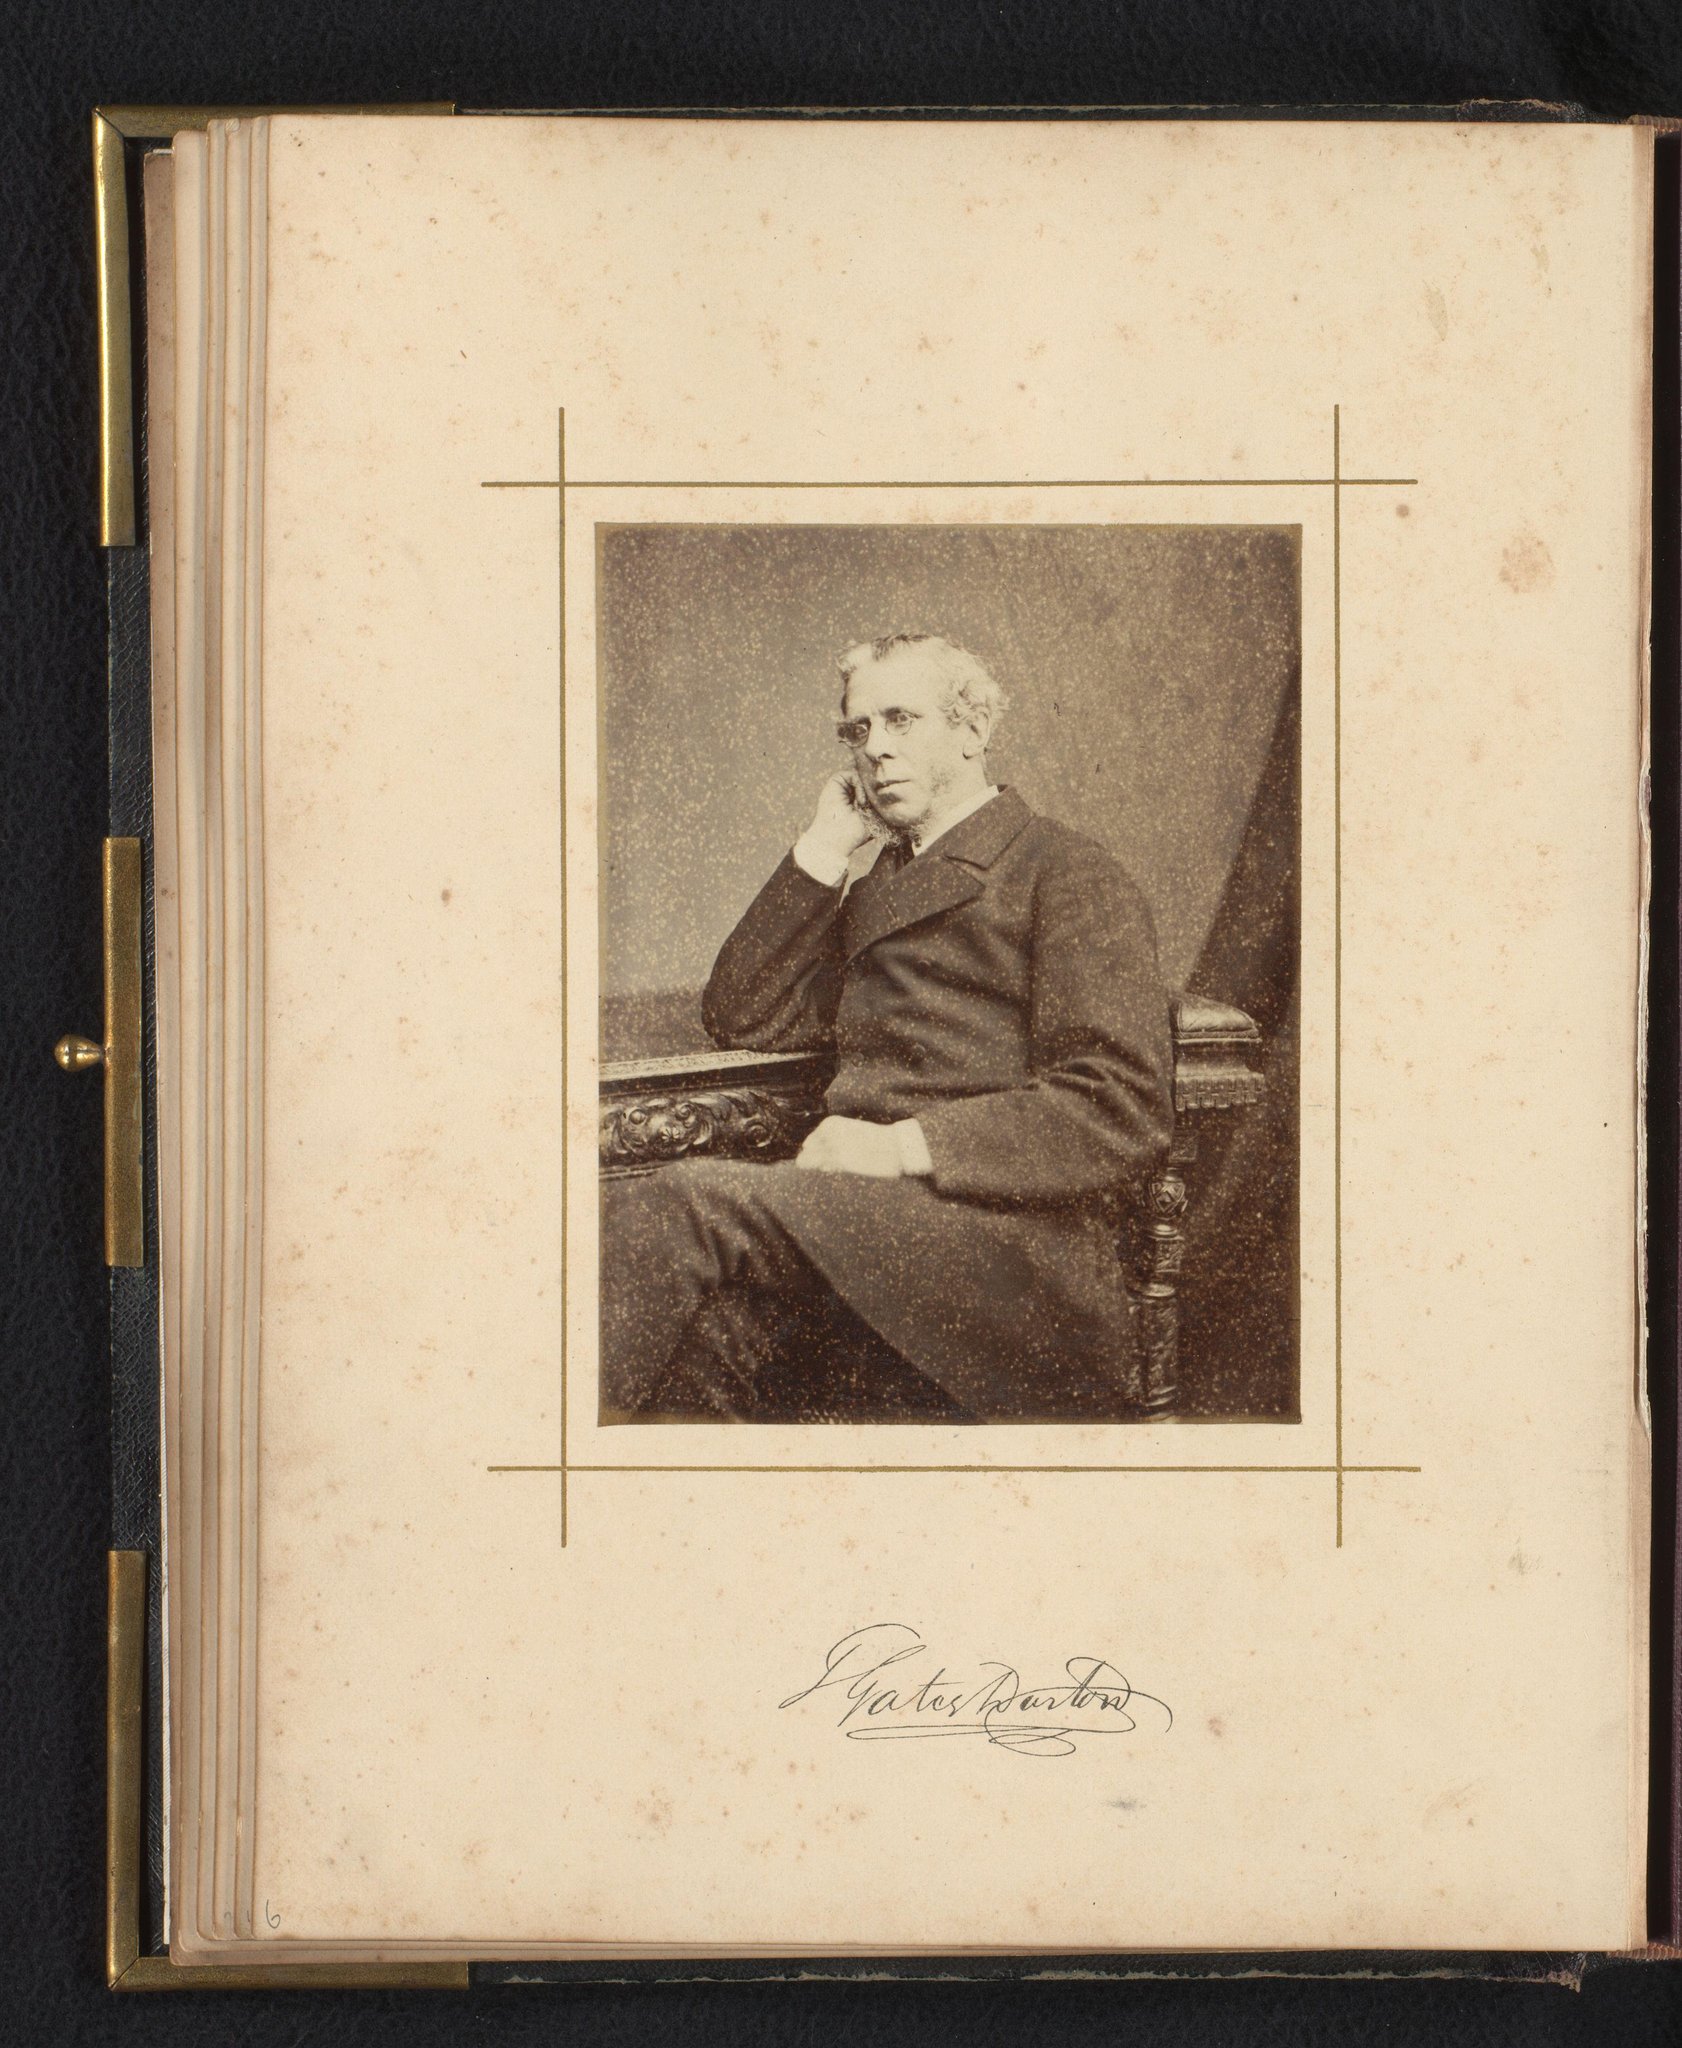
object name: page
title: Portret van Thomas Gates Darton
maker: Anonymous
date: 1866-1871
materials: photographic support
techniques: albumen print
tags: historical persons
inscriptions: name: ‘T Gates Darton’